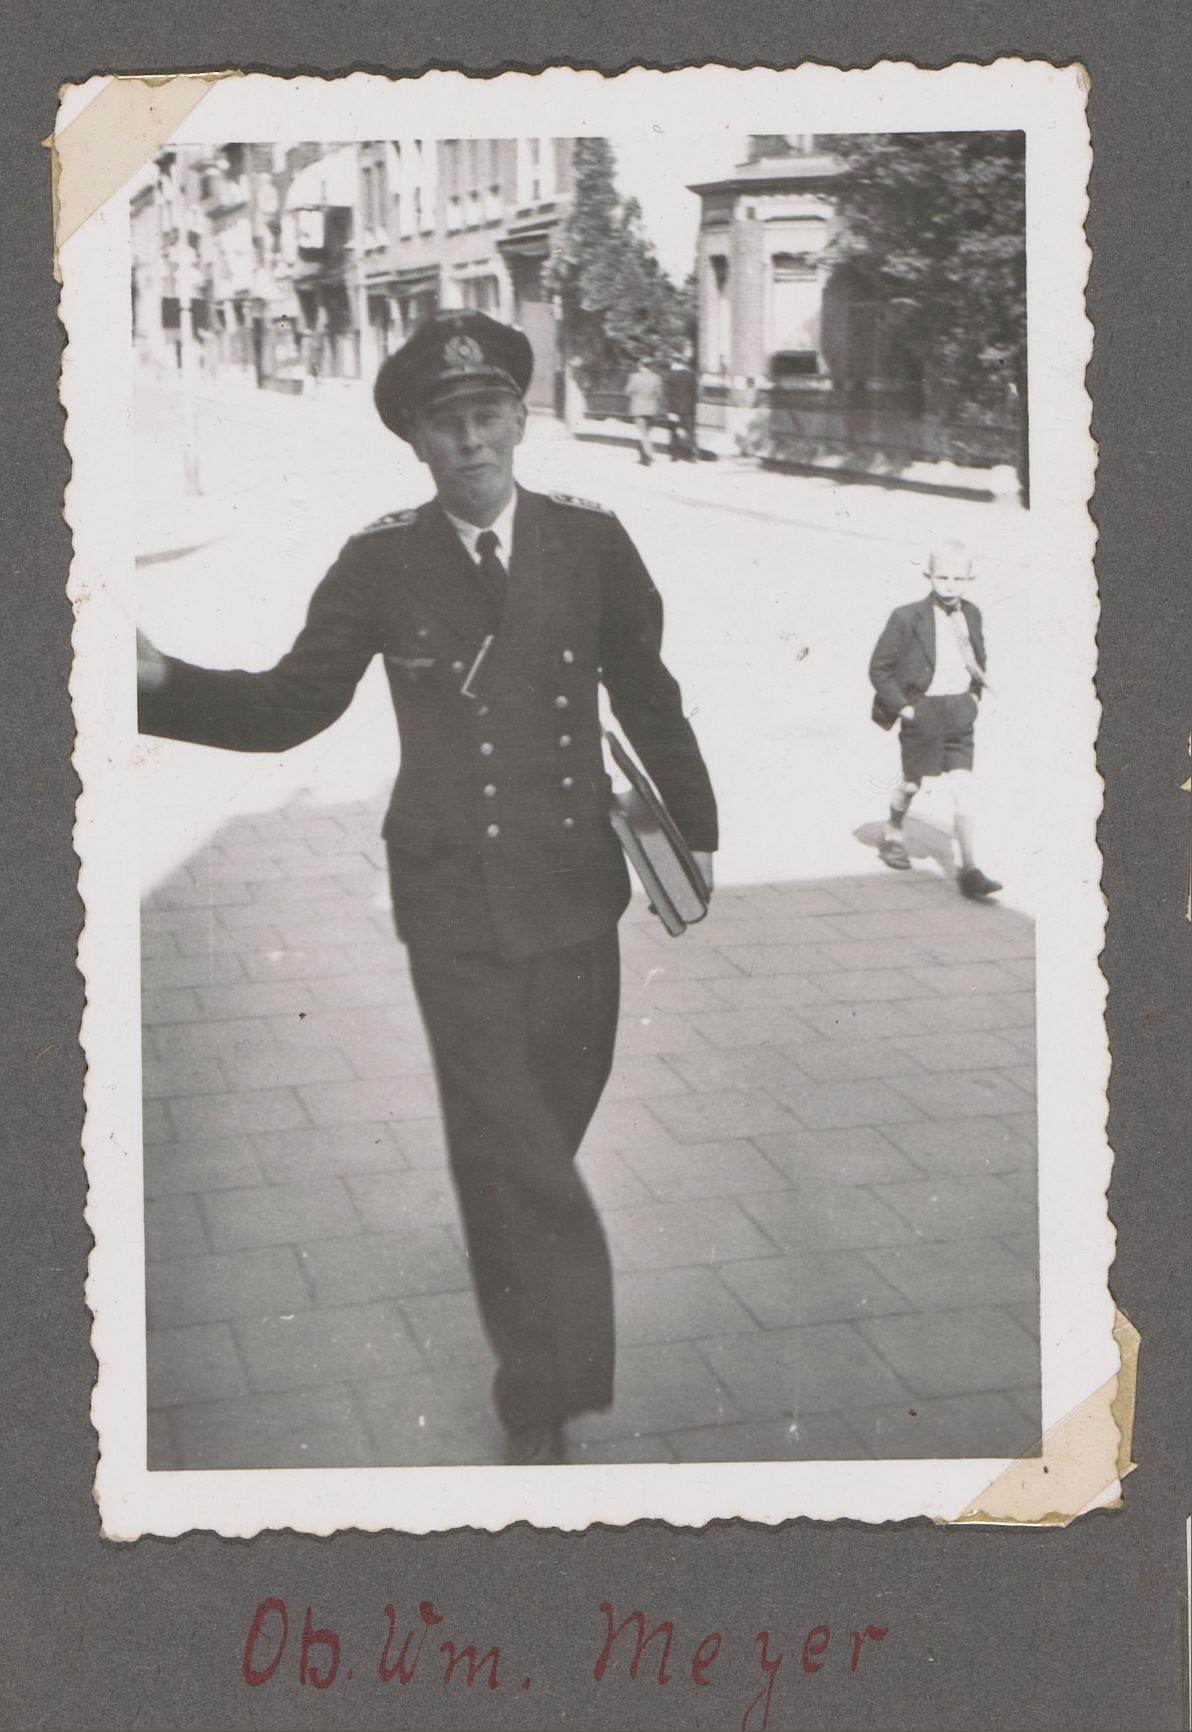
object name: album leaf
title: Ob. Wm. Meyer op straat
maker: Anonymous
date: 1941-1945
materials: paper, photographic support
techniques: gelatin silver print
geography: netherlands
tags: adult man, historical persons, the soldier; the soldier's life, street, netherlands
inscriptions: annotation: ‘Ob. Wm. Meyer’